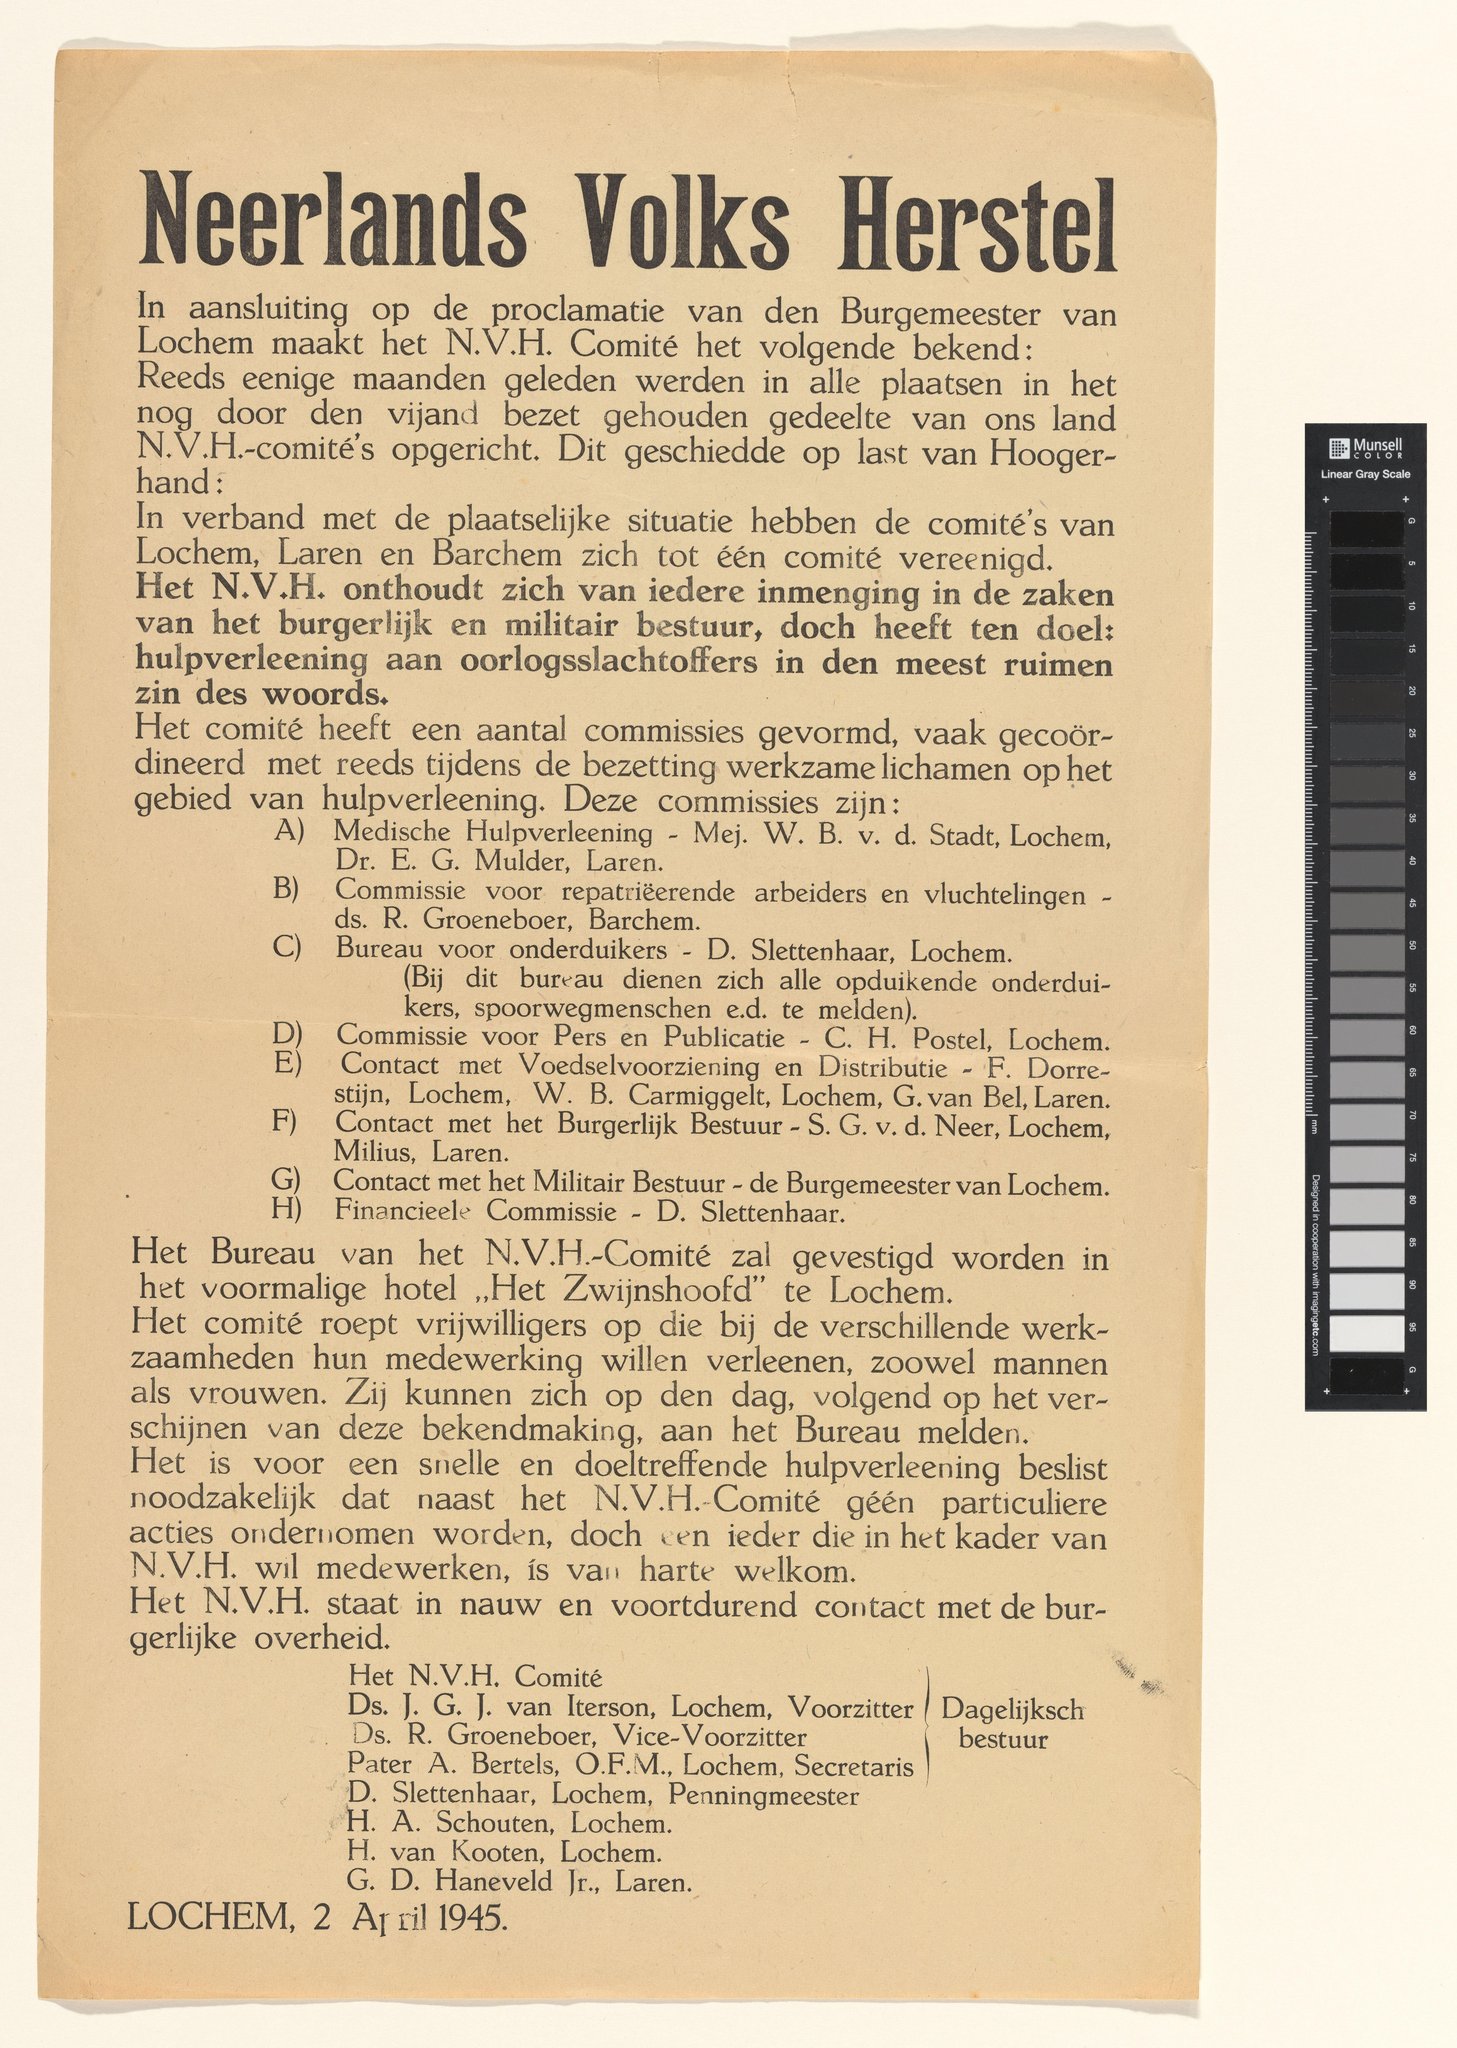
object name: poster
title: Neerlands Volks Herstel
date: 1904-1945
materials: cardboard, paper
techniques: printing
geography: lochem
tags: netherlands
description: Aanplakbiljet. Eénzijdig bedrukt op blanco papier, waarin het NVH comite haar taak uit de doeken doet.